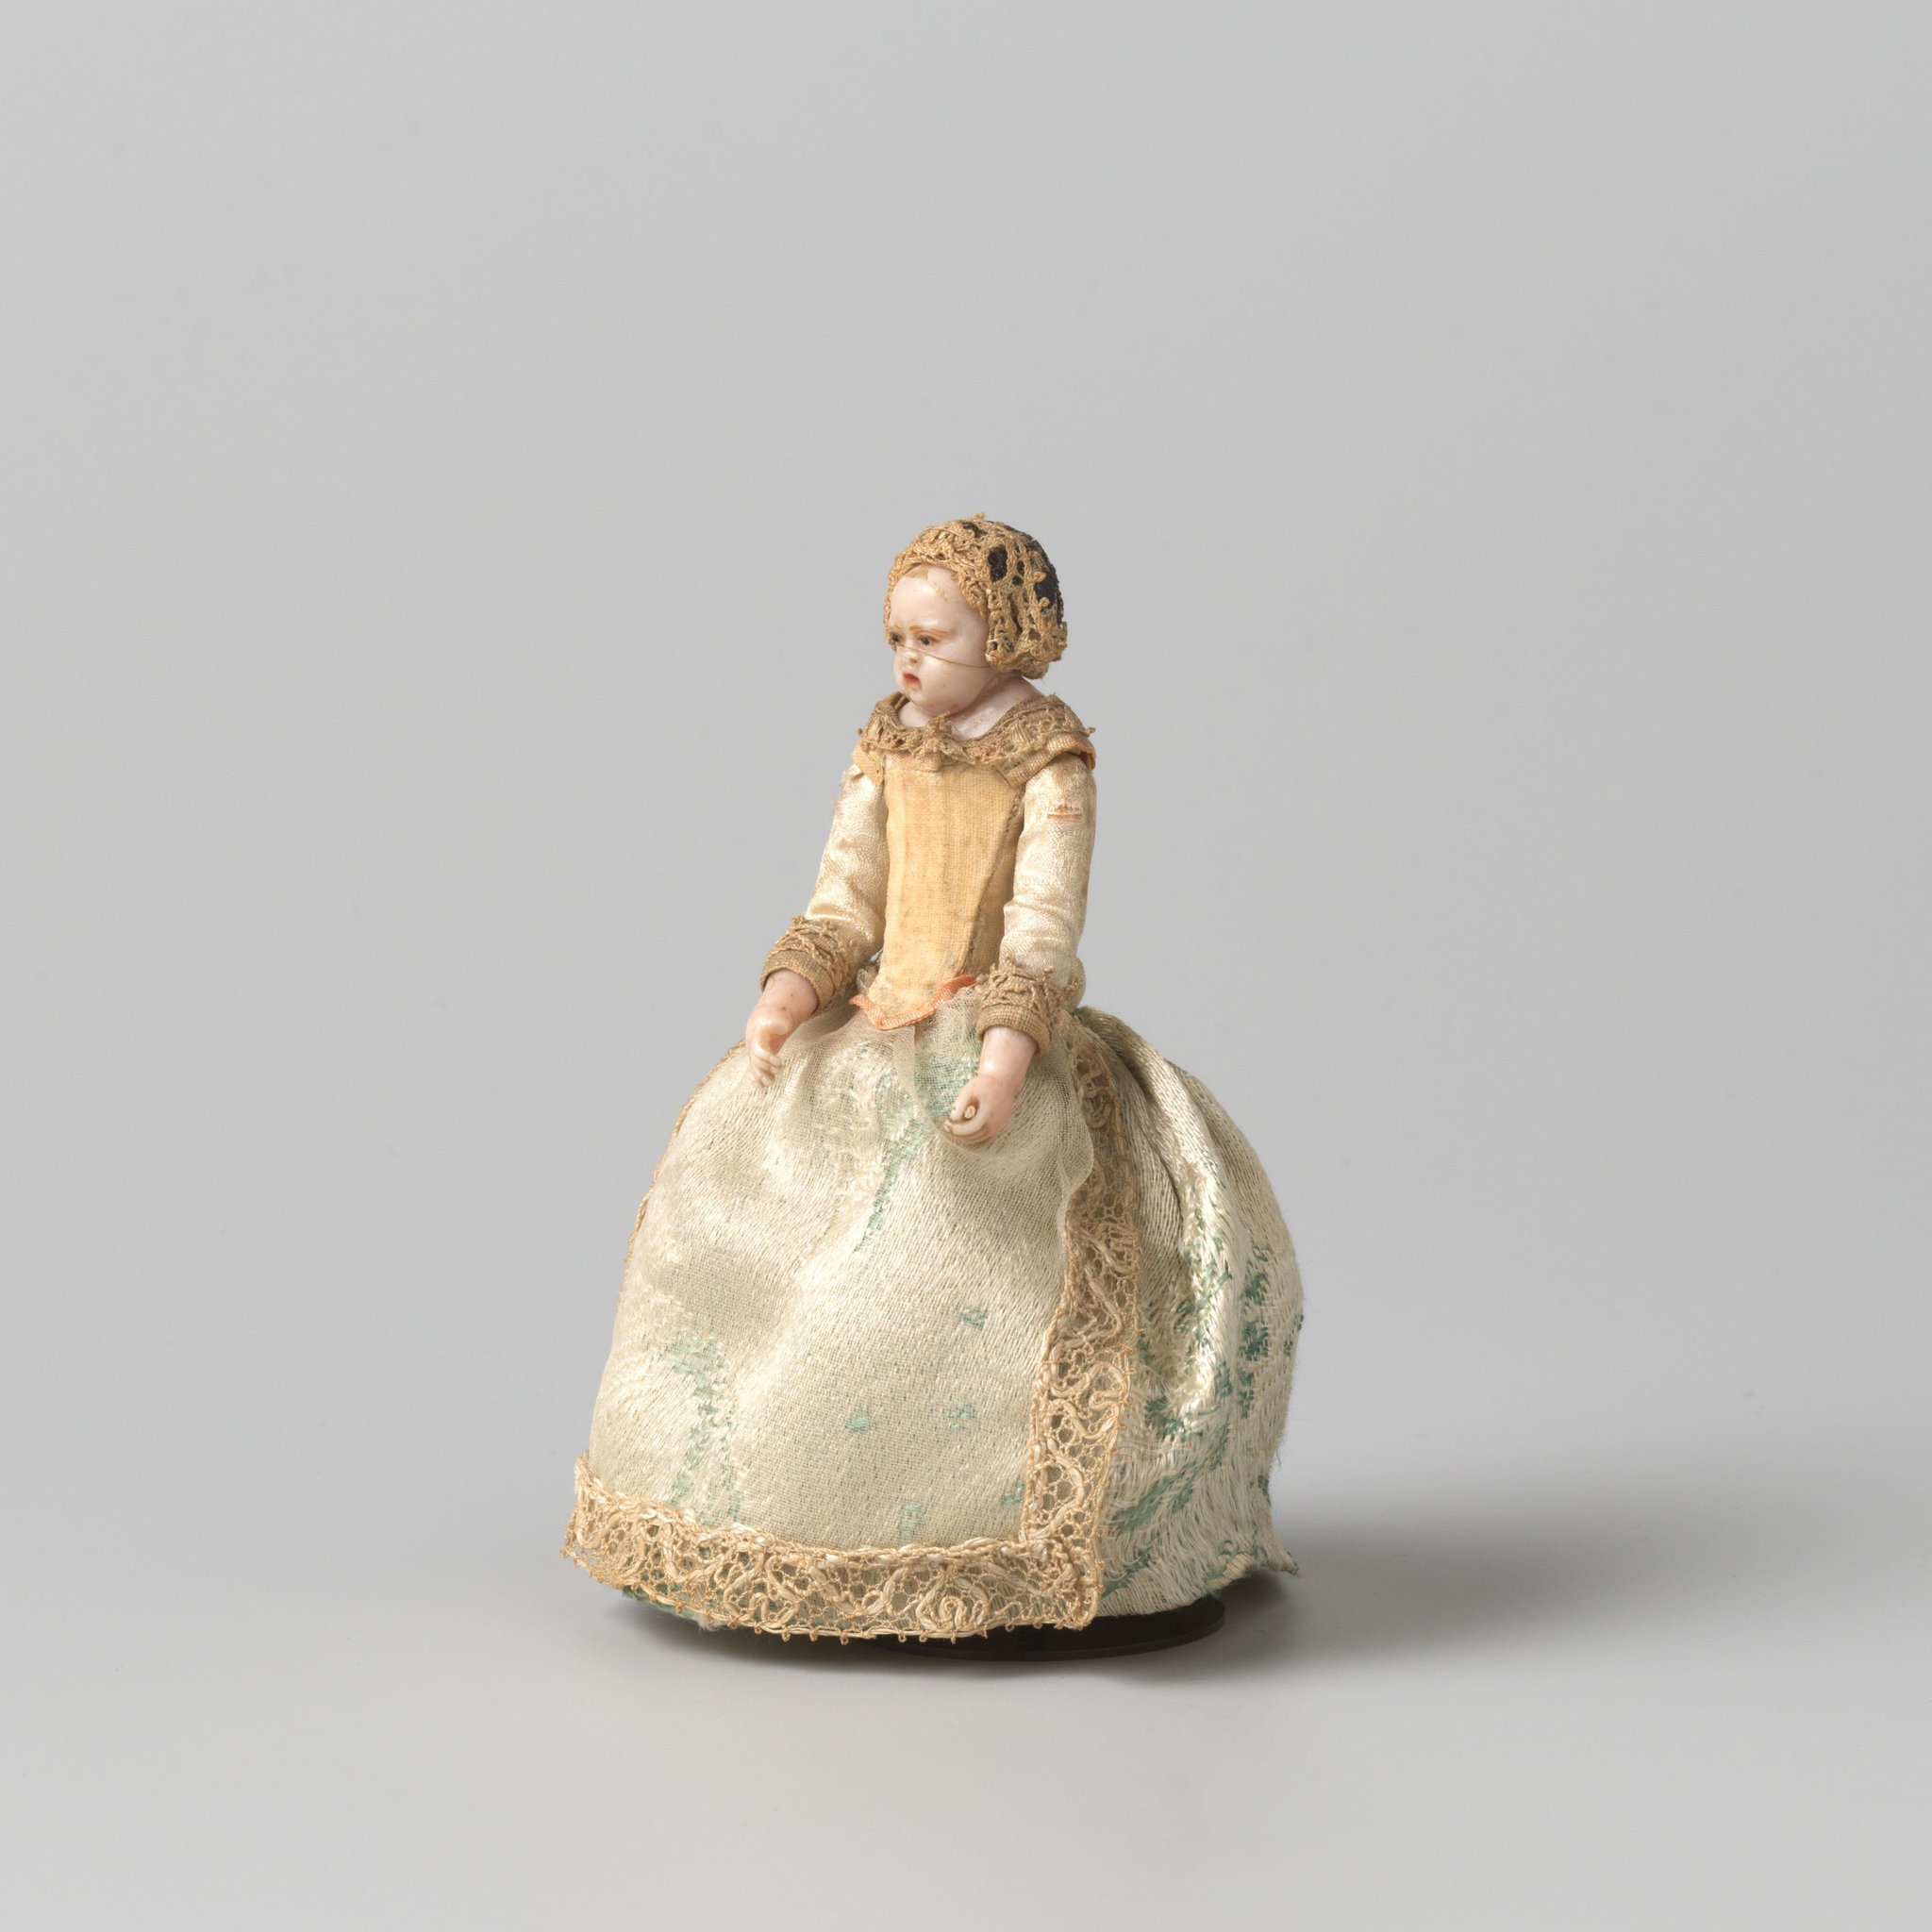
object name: miniature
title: Pop, voorstellende een meisje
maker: Anonymous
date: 1676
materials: linen, silk, vegetable tanned sheepskin, wax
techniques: lace, damask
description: Pop, voorstellende een meisje, gekleed in een crèmekleurig linnen lijfje, mouwen van crèmekleurige zijdedamast, een voetlange rok van wit en lichtgroene zijdedamast, waarover een gazen schort.